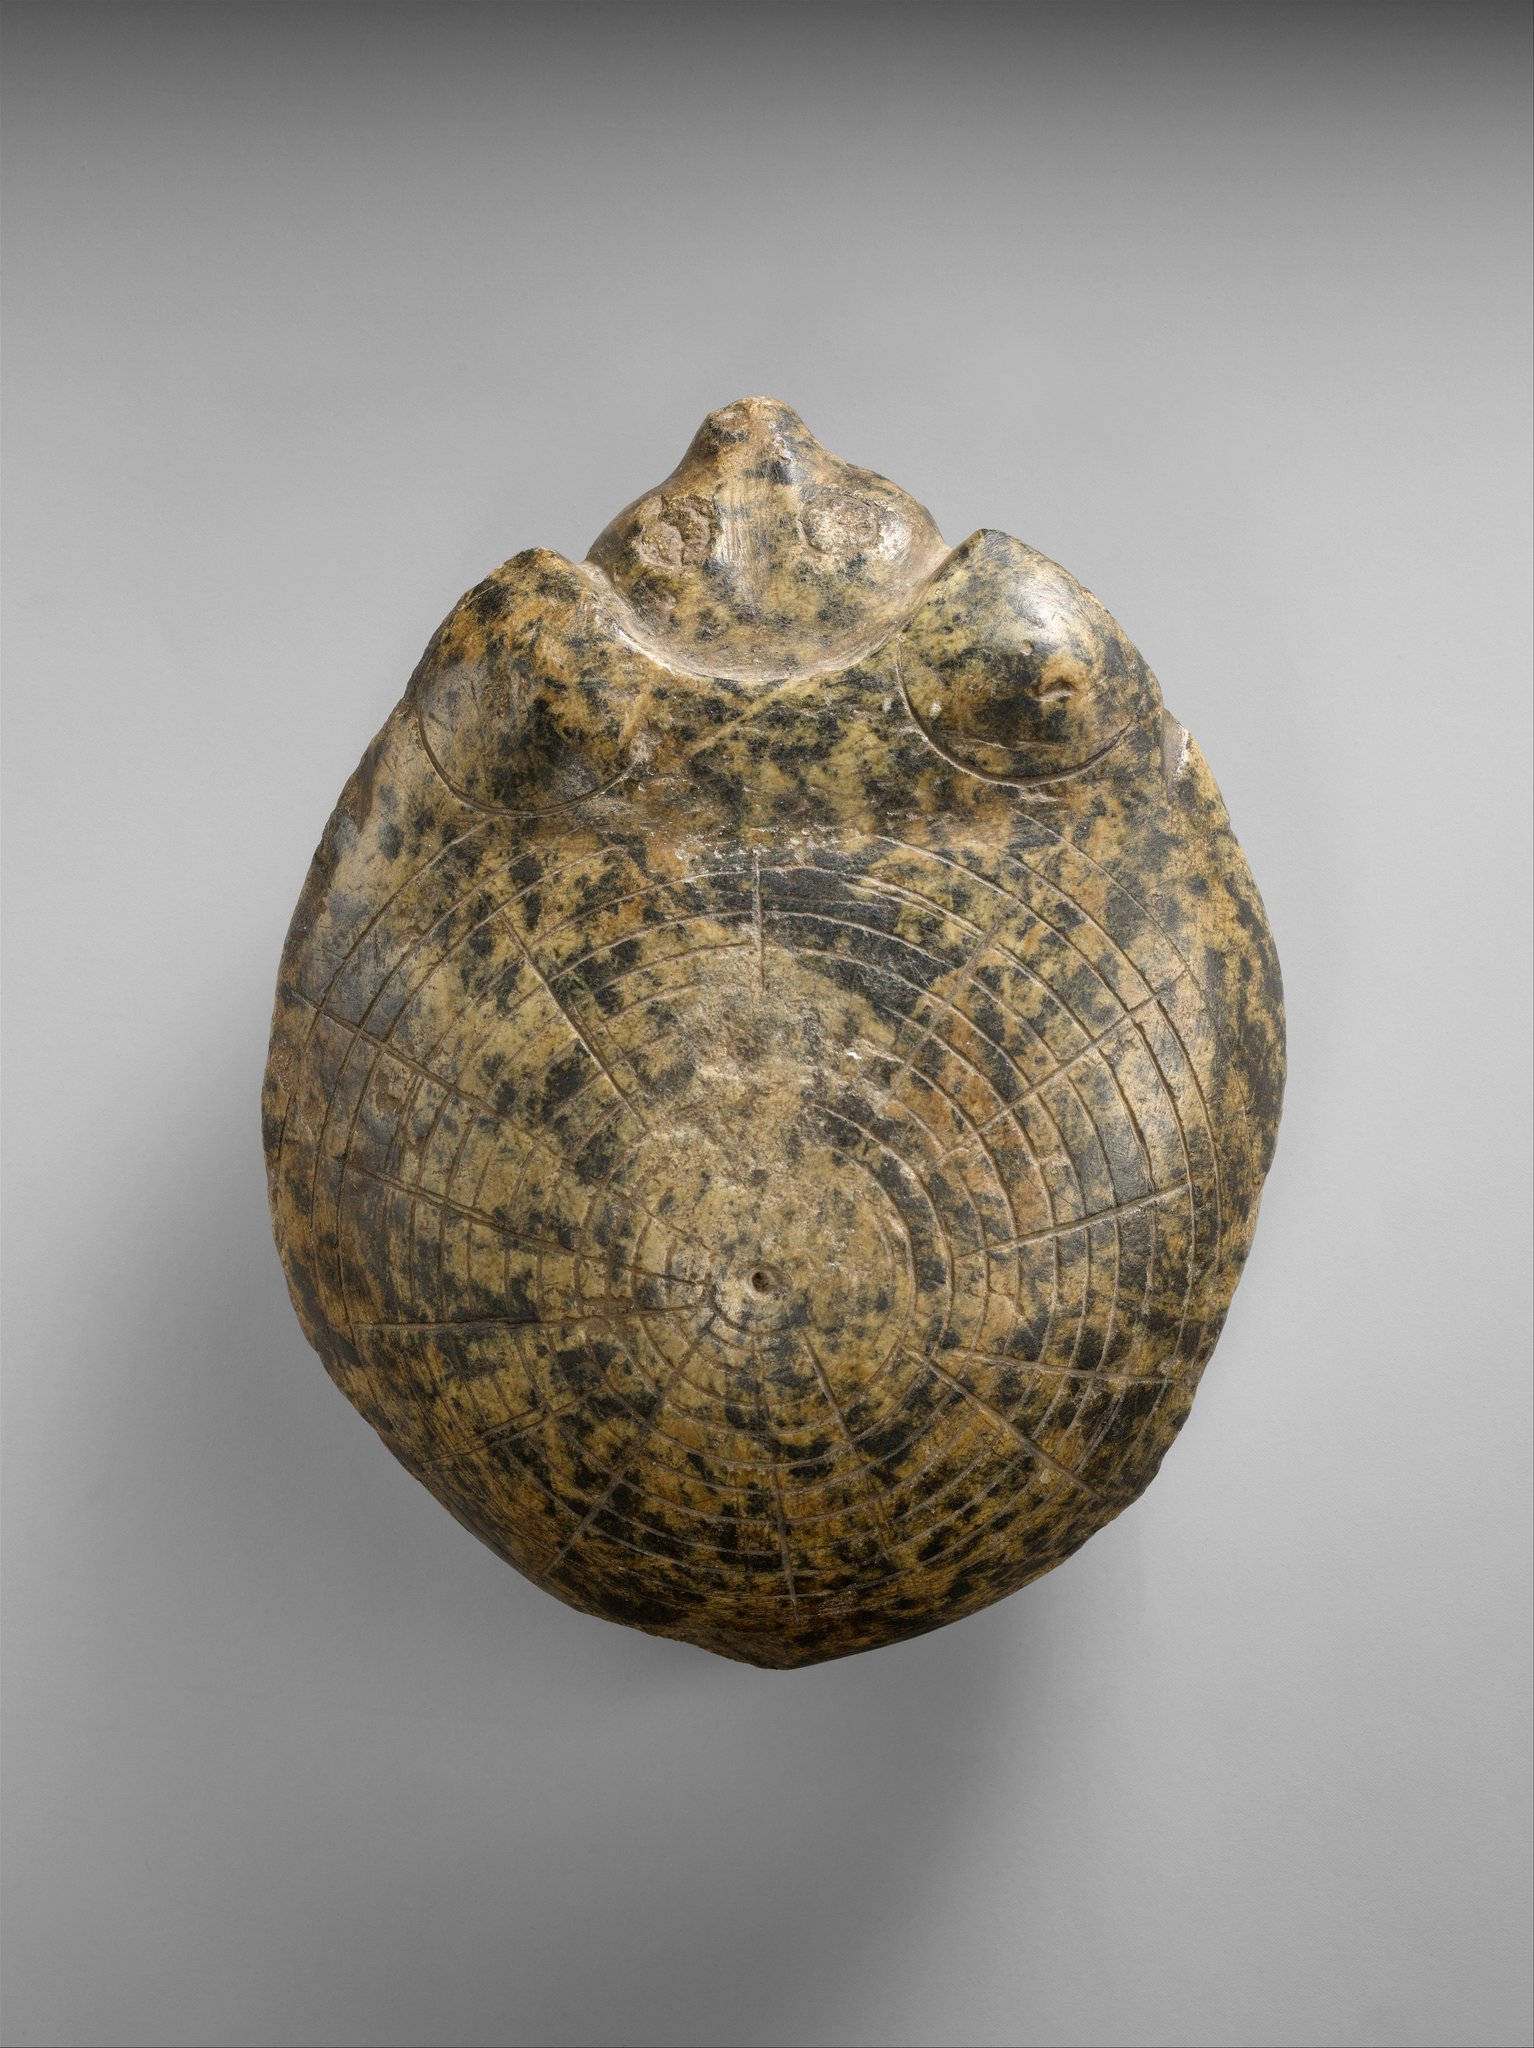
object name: figurine, turtle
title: Turtle as a Votive Mehen Game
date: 3100-2649 BCE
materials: stone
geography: egypt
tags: turtles,games